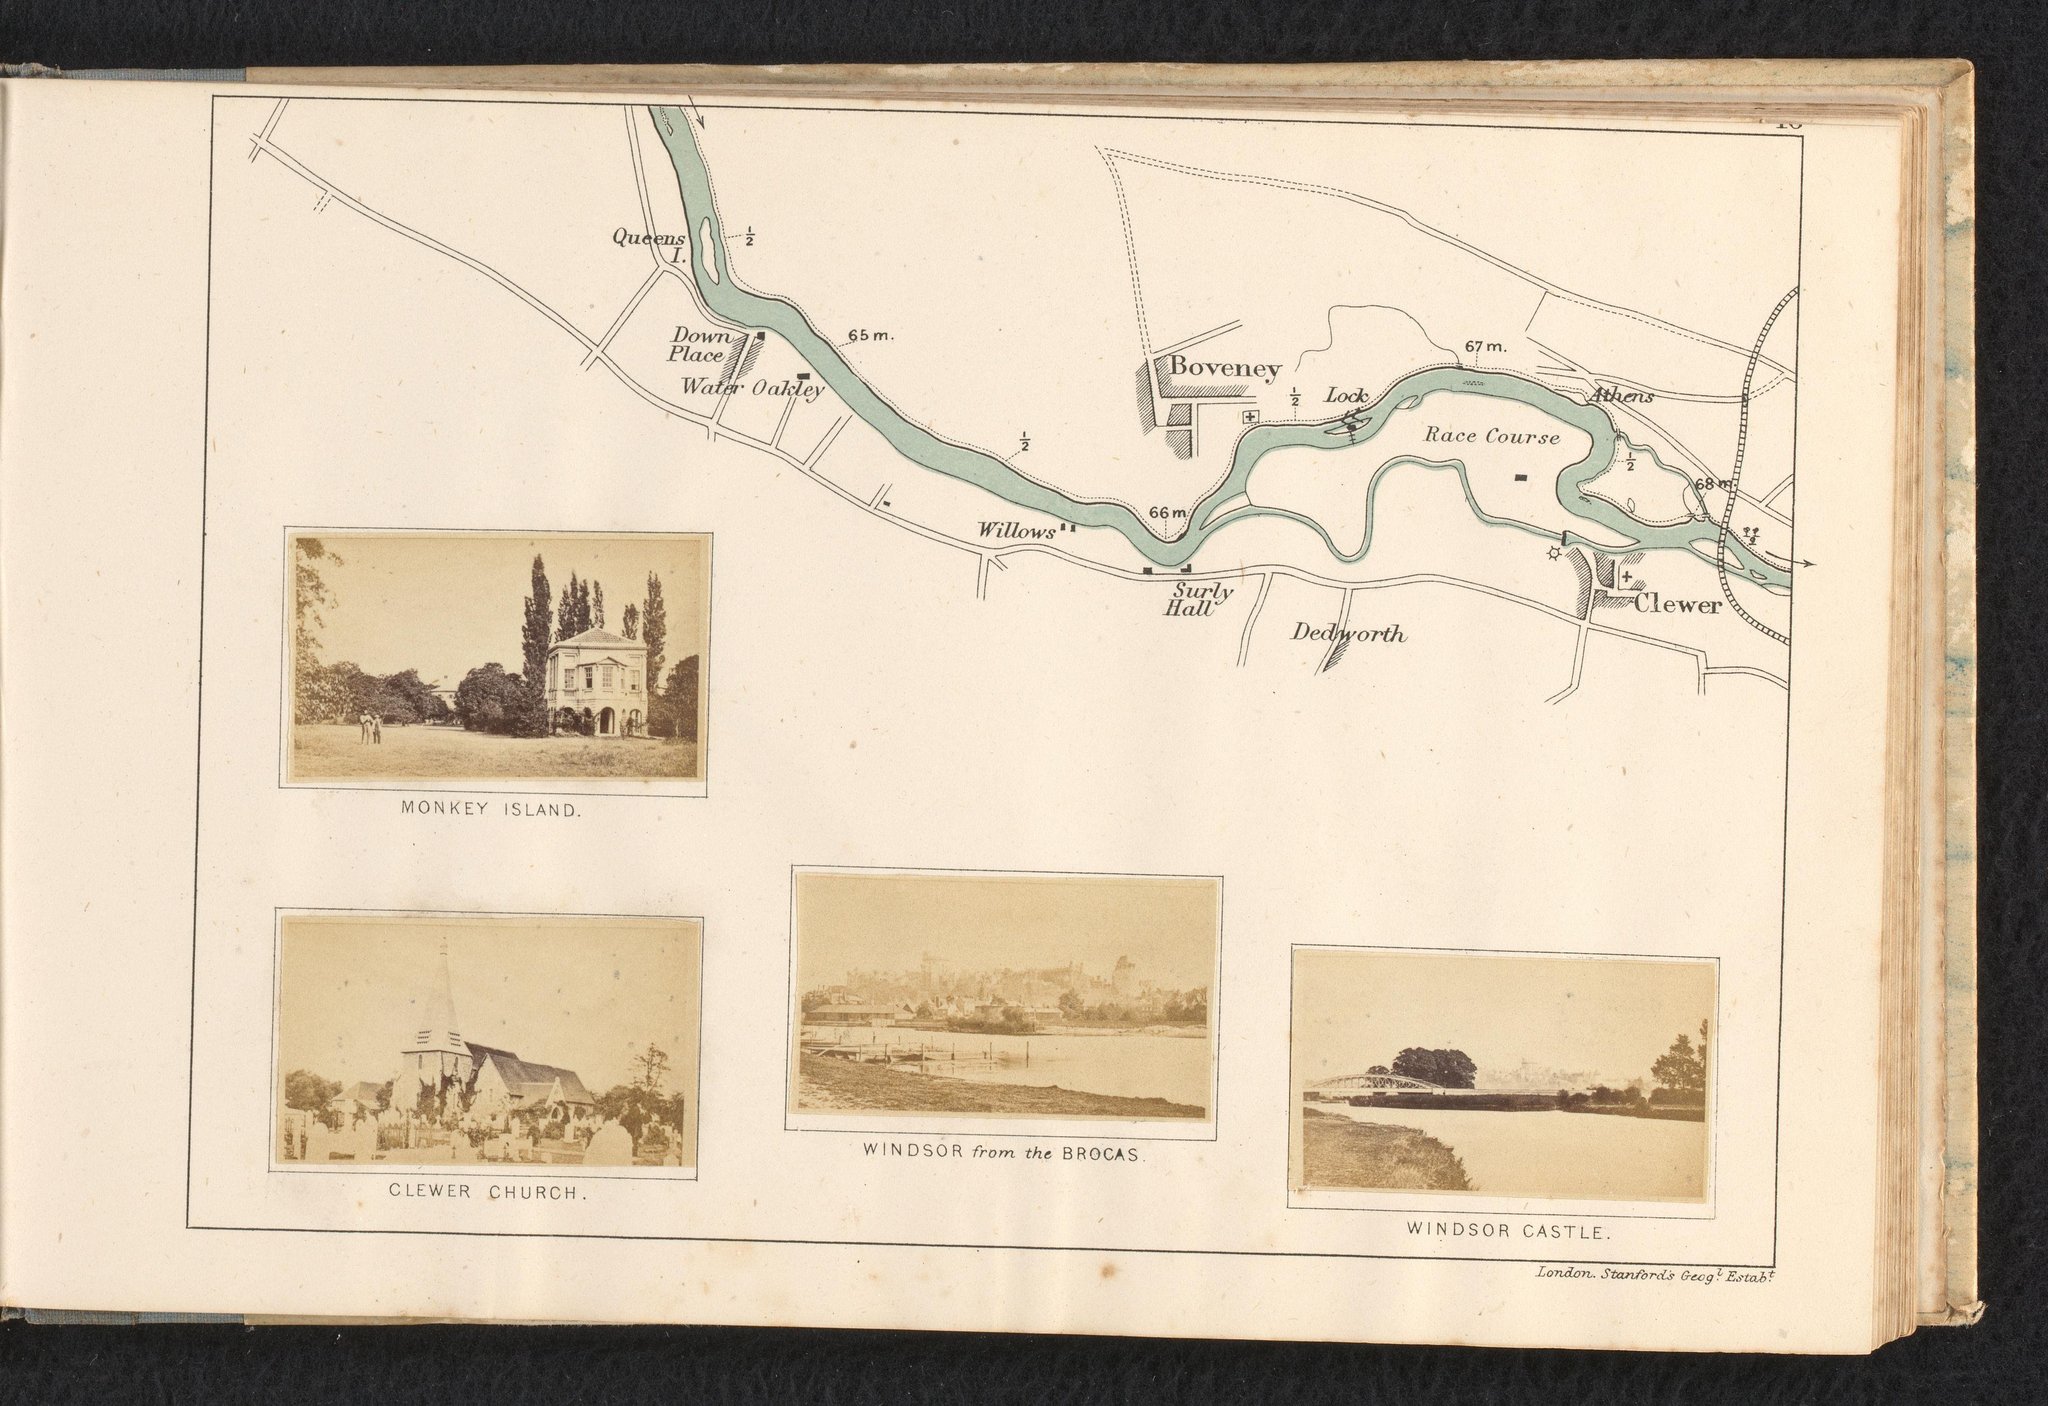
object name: photograph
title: Monkey Island, Clewer Church, Windsor from the Brocas, Windsor Castle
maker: Anonymous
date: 1868-1873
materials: paper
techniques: albumen print, letterpress printing, line block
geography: berkshire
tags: landscapes in the temperate zone, river bank, landscape with bridge, viaduct or aqueduct, church (exterior), villa, churchyard, cemetery